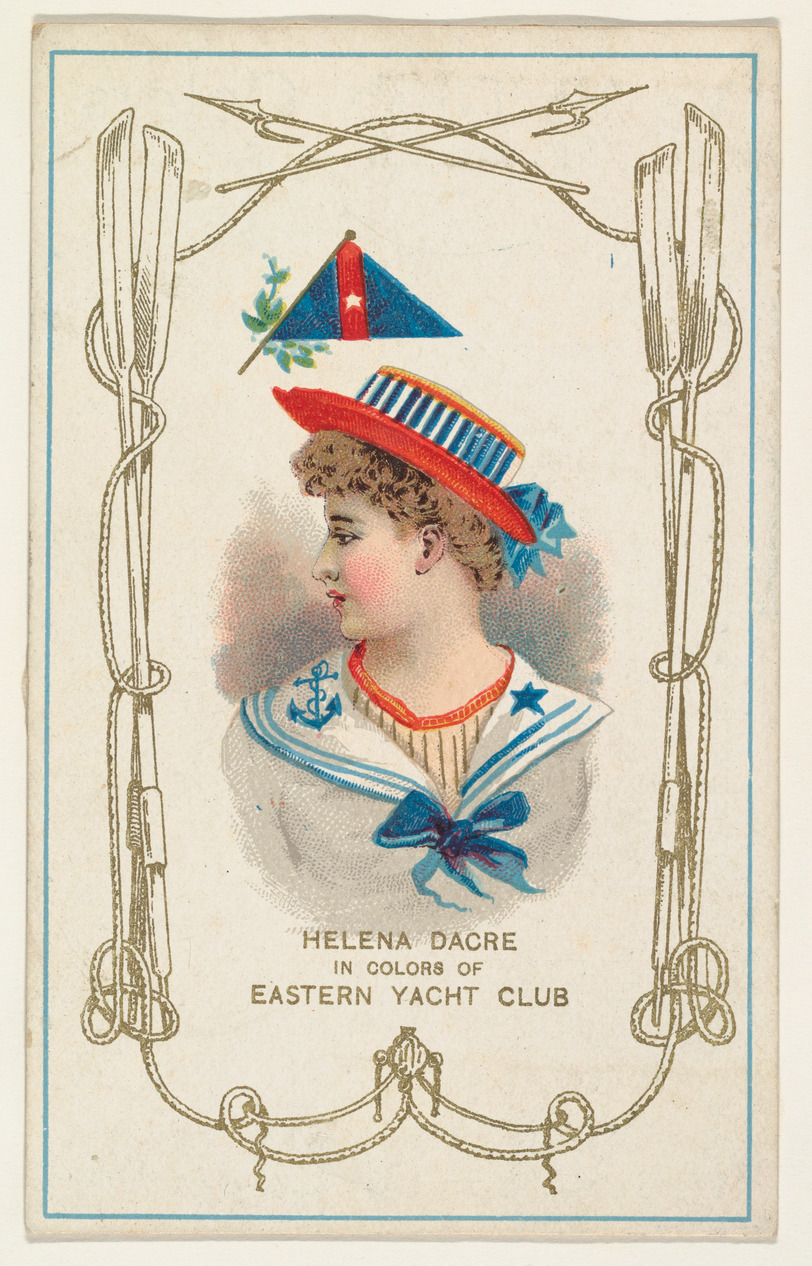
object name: print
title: Helena Dacre in Colors of Eastern Yacht Club, from the Yacht Colors of the World series (N140) issued by Duke Sons & Co. to promote Honest Long Cut Tobacco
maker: w. duke, sons & co.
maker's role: publisher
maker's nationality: american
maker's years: 1870-1920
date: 1890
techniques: color lithograph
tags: profiles,women,flags